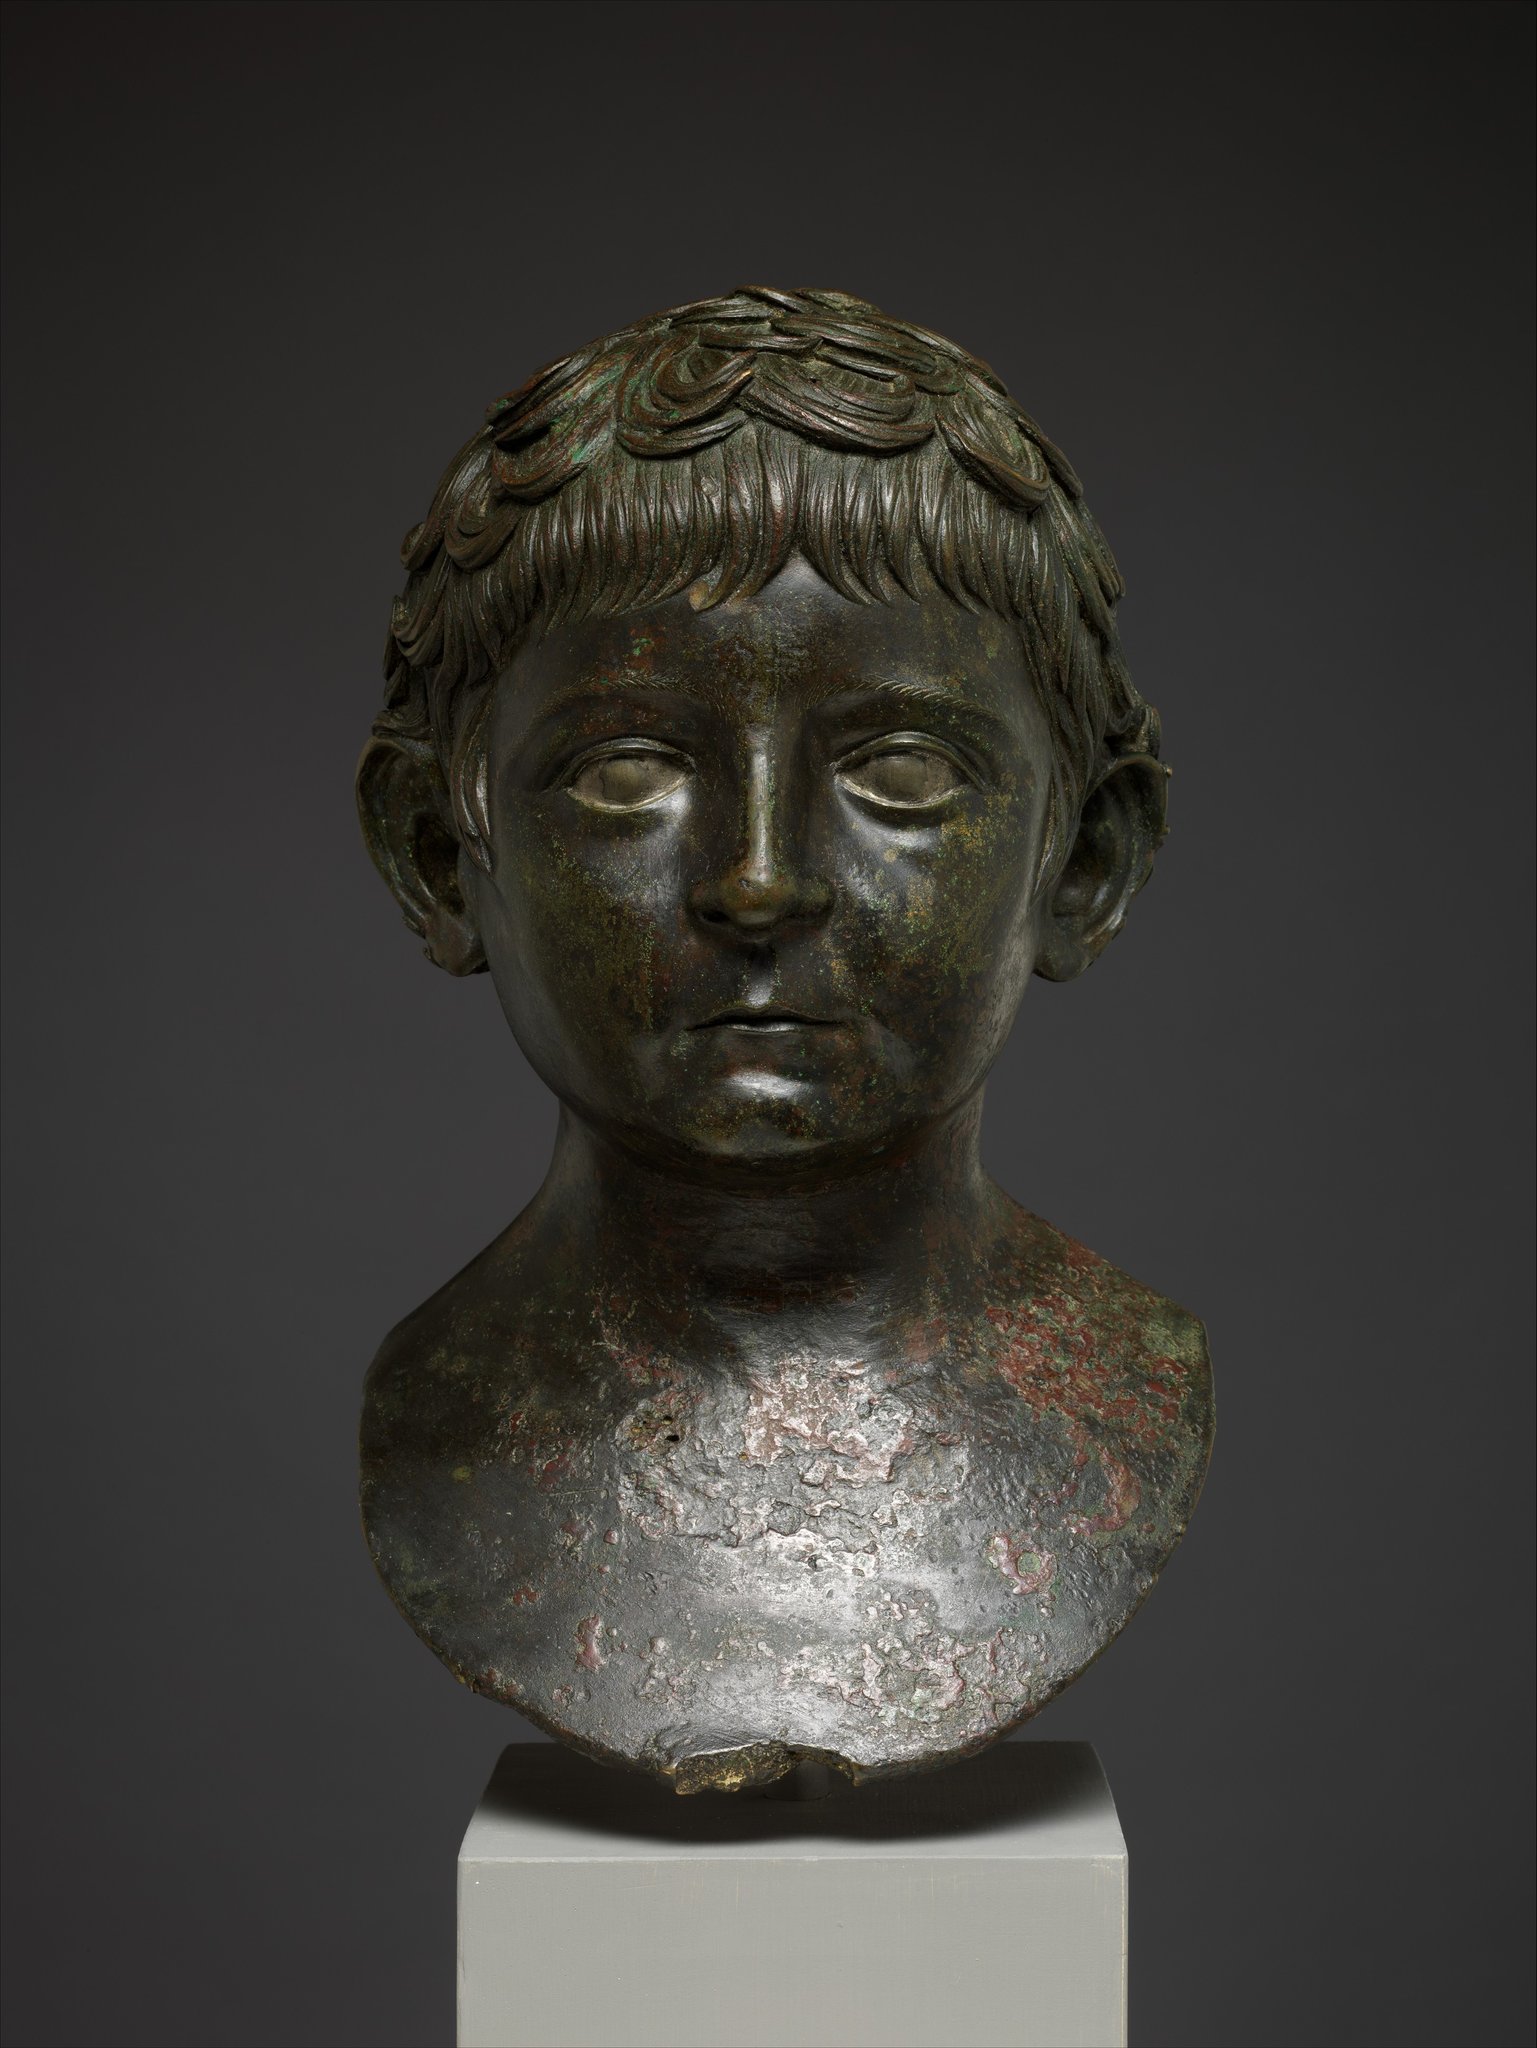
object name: portrait bust of a boy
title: Bronze portrait bust of a young boy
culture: roman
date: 50-68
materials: bronze, silver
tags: boys,portraits